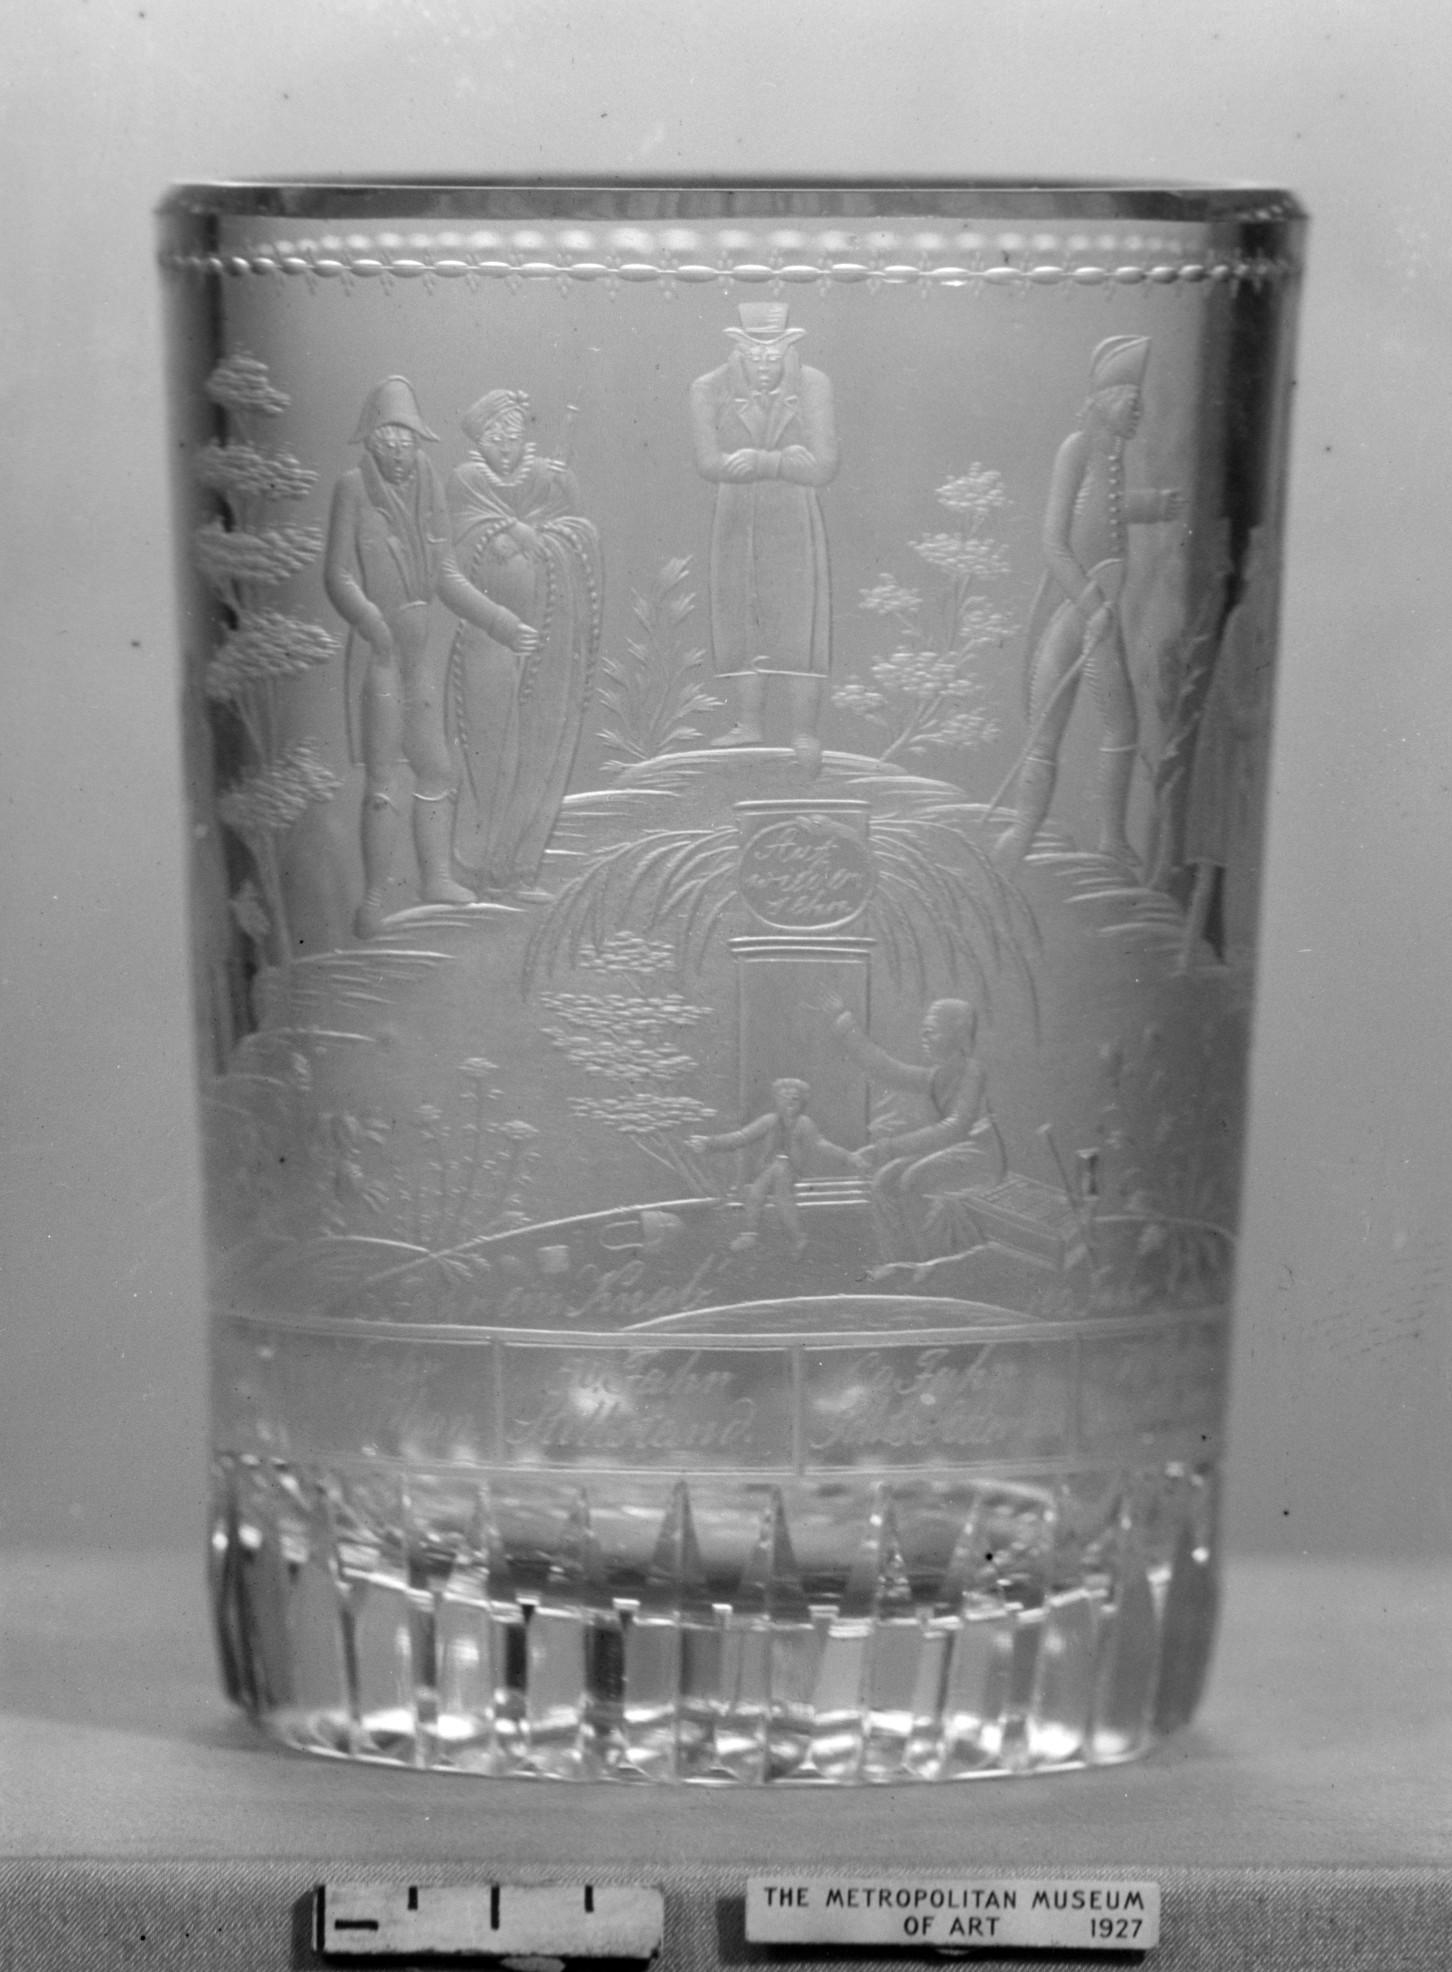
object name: beaker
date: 1820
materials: glass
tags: children,men,women